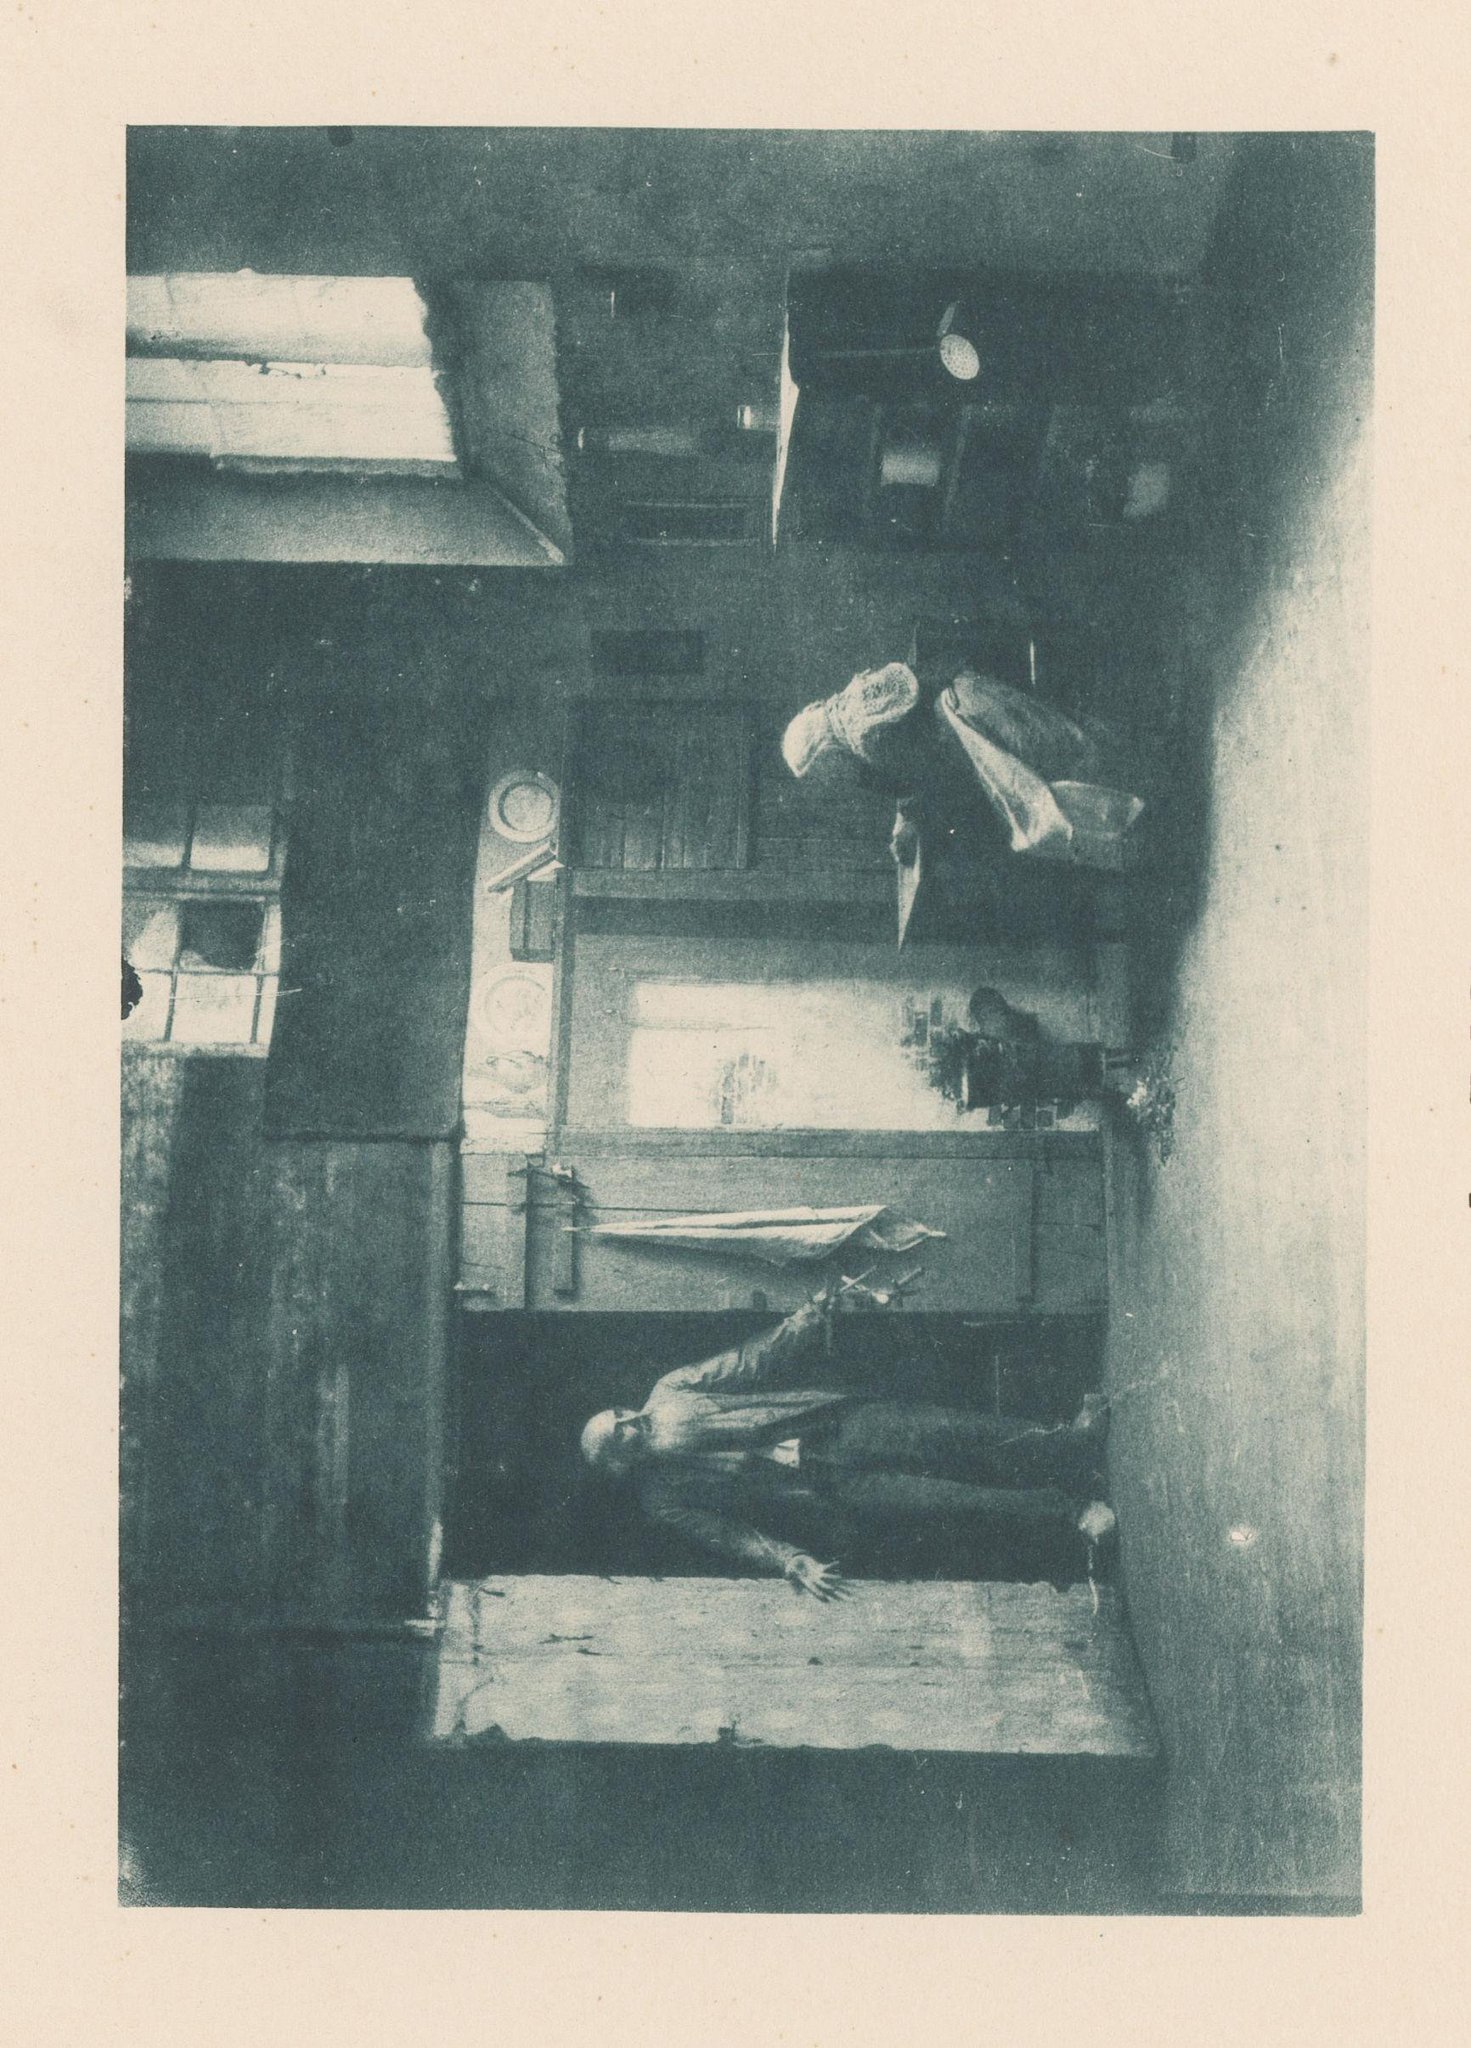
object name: photomechanical print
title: Sentiment d'Art en Photographie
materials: paper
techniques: photograph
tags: adult woman, adult man, interior of the house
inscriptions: number: ‘Vol. 1, No 2, Planche 1.’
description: Deze prent maakt deel uit van 8 omslagen met 22 tekstbladen en 89 prenten op losse bladen in en tussen de omslagen.